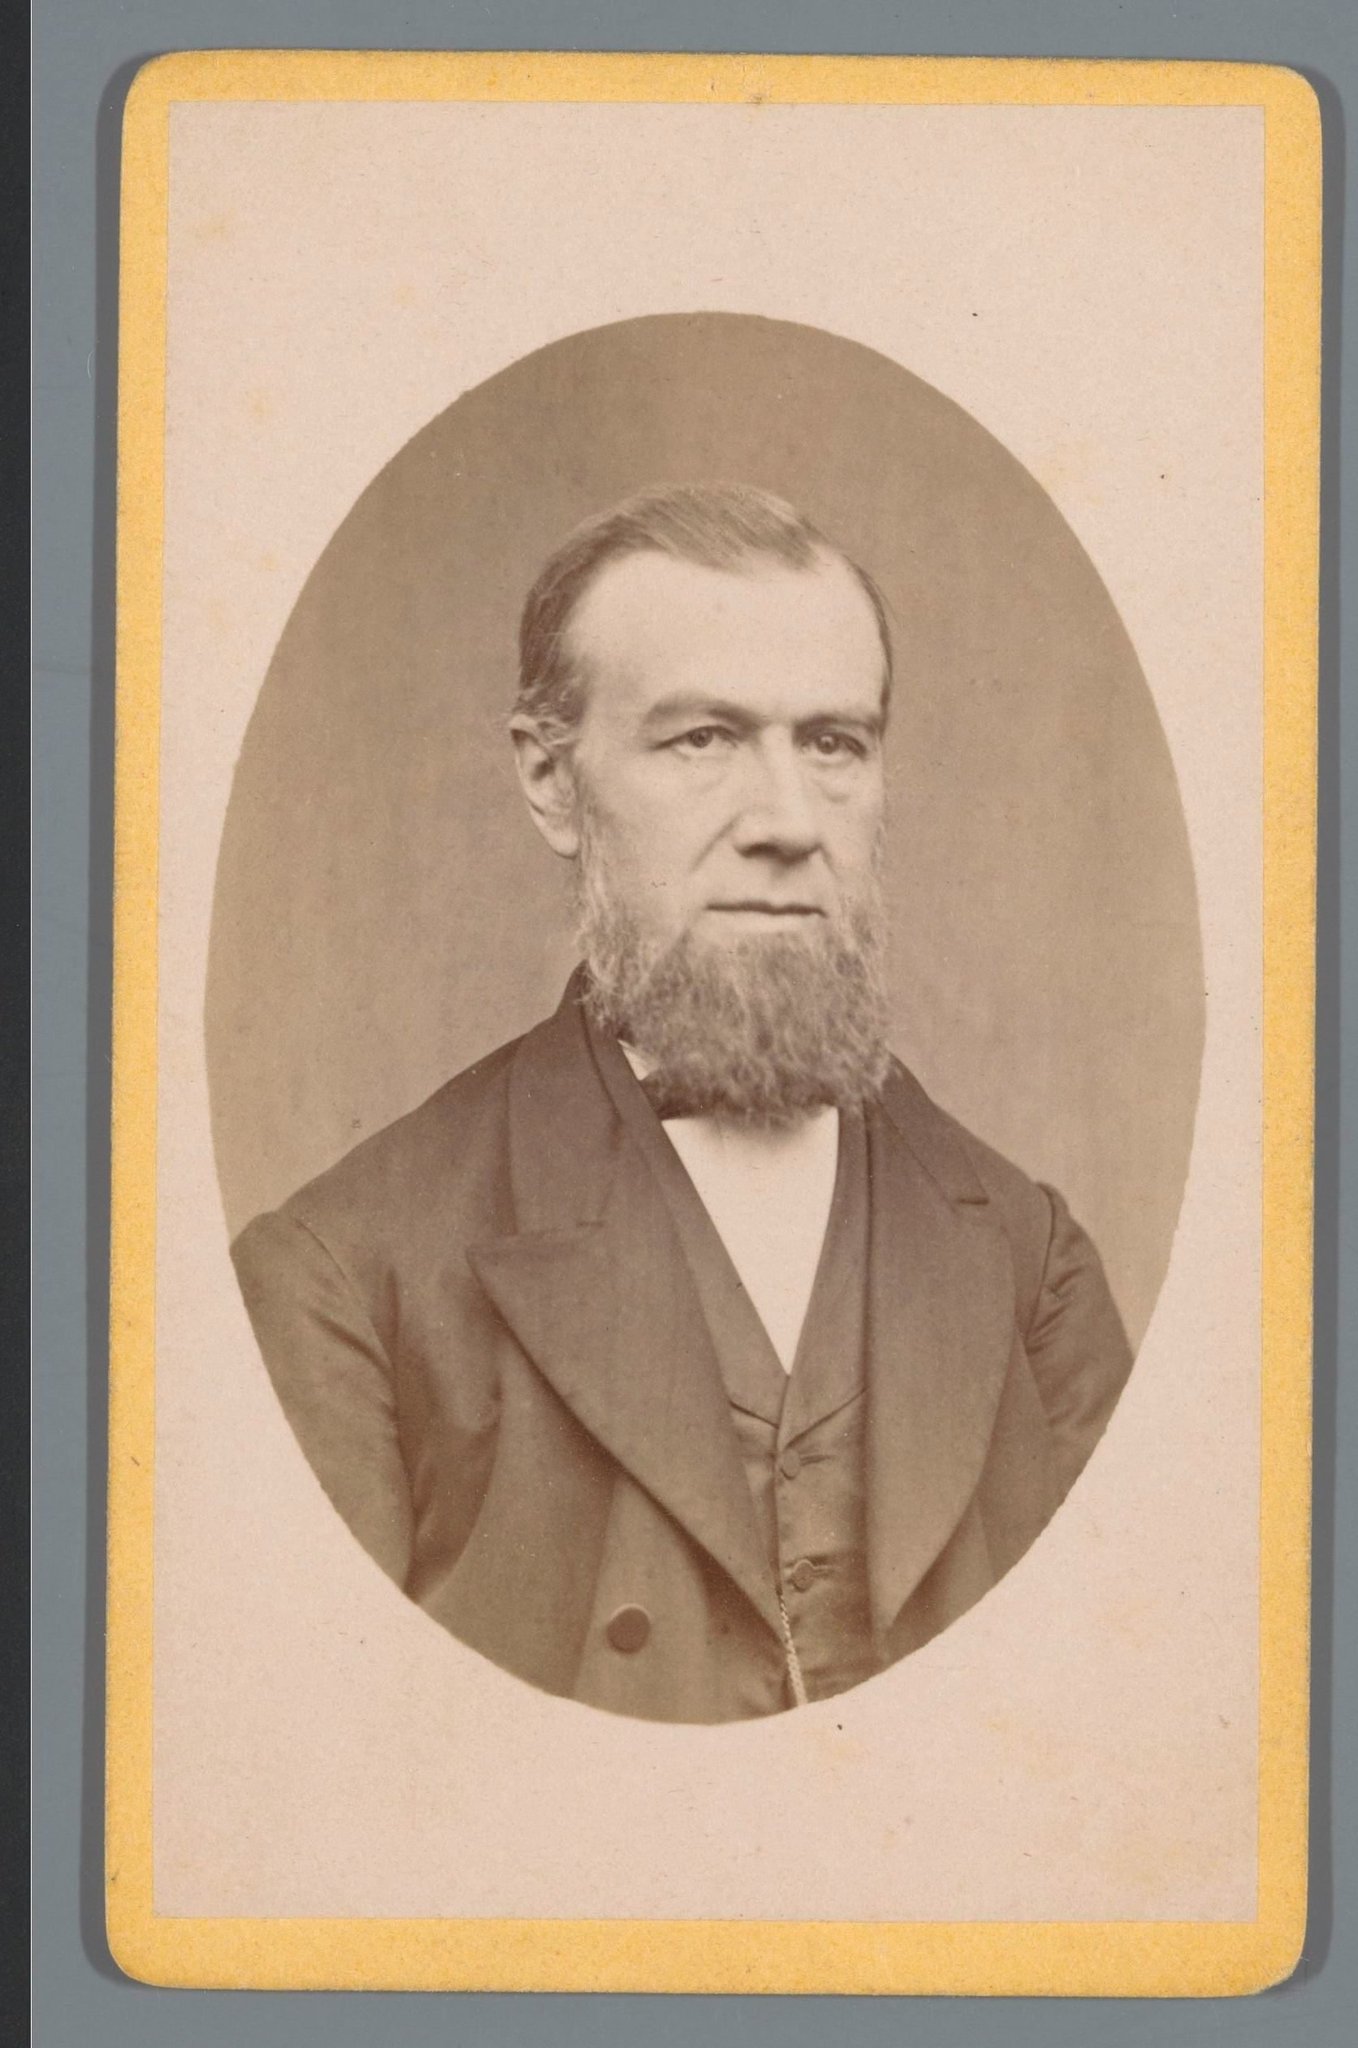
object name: carte de visite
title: Portret van een onbekende man met baard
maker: benjamin van der heide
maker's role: fotograaf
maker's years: 1837-1928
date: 1879-1882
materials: cardboard, paper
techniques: albumen print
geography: harlingen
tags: historical persons, beard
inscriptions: inscription: ‘Photographisch Atelier/ van/ B. VAN DER HEIDE/ te/ HARLINGEN./ Voor Nabestellingen blijven de Platen bewaard.’, inscription: ‘slijpen’